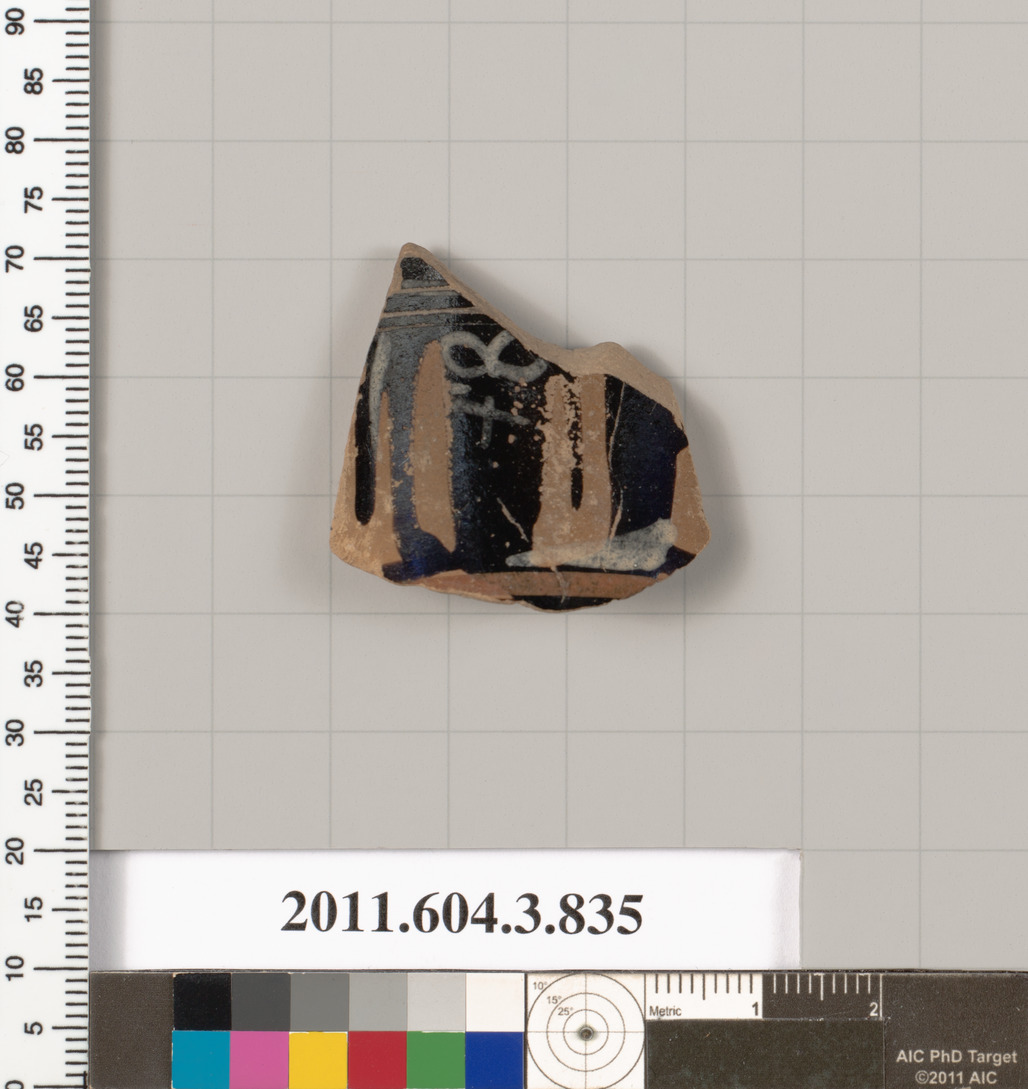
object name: lekythos fragment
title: Terracotta fragment of a lekythos (oil flask)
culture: greek, attic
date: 534-468 BCE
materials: terracotta